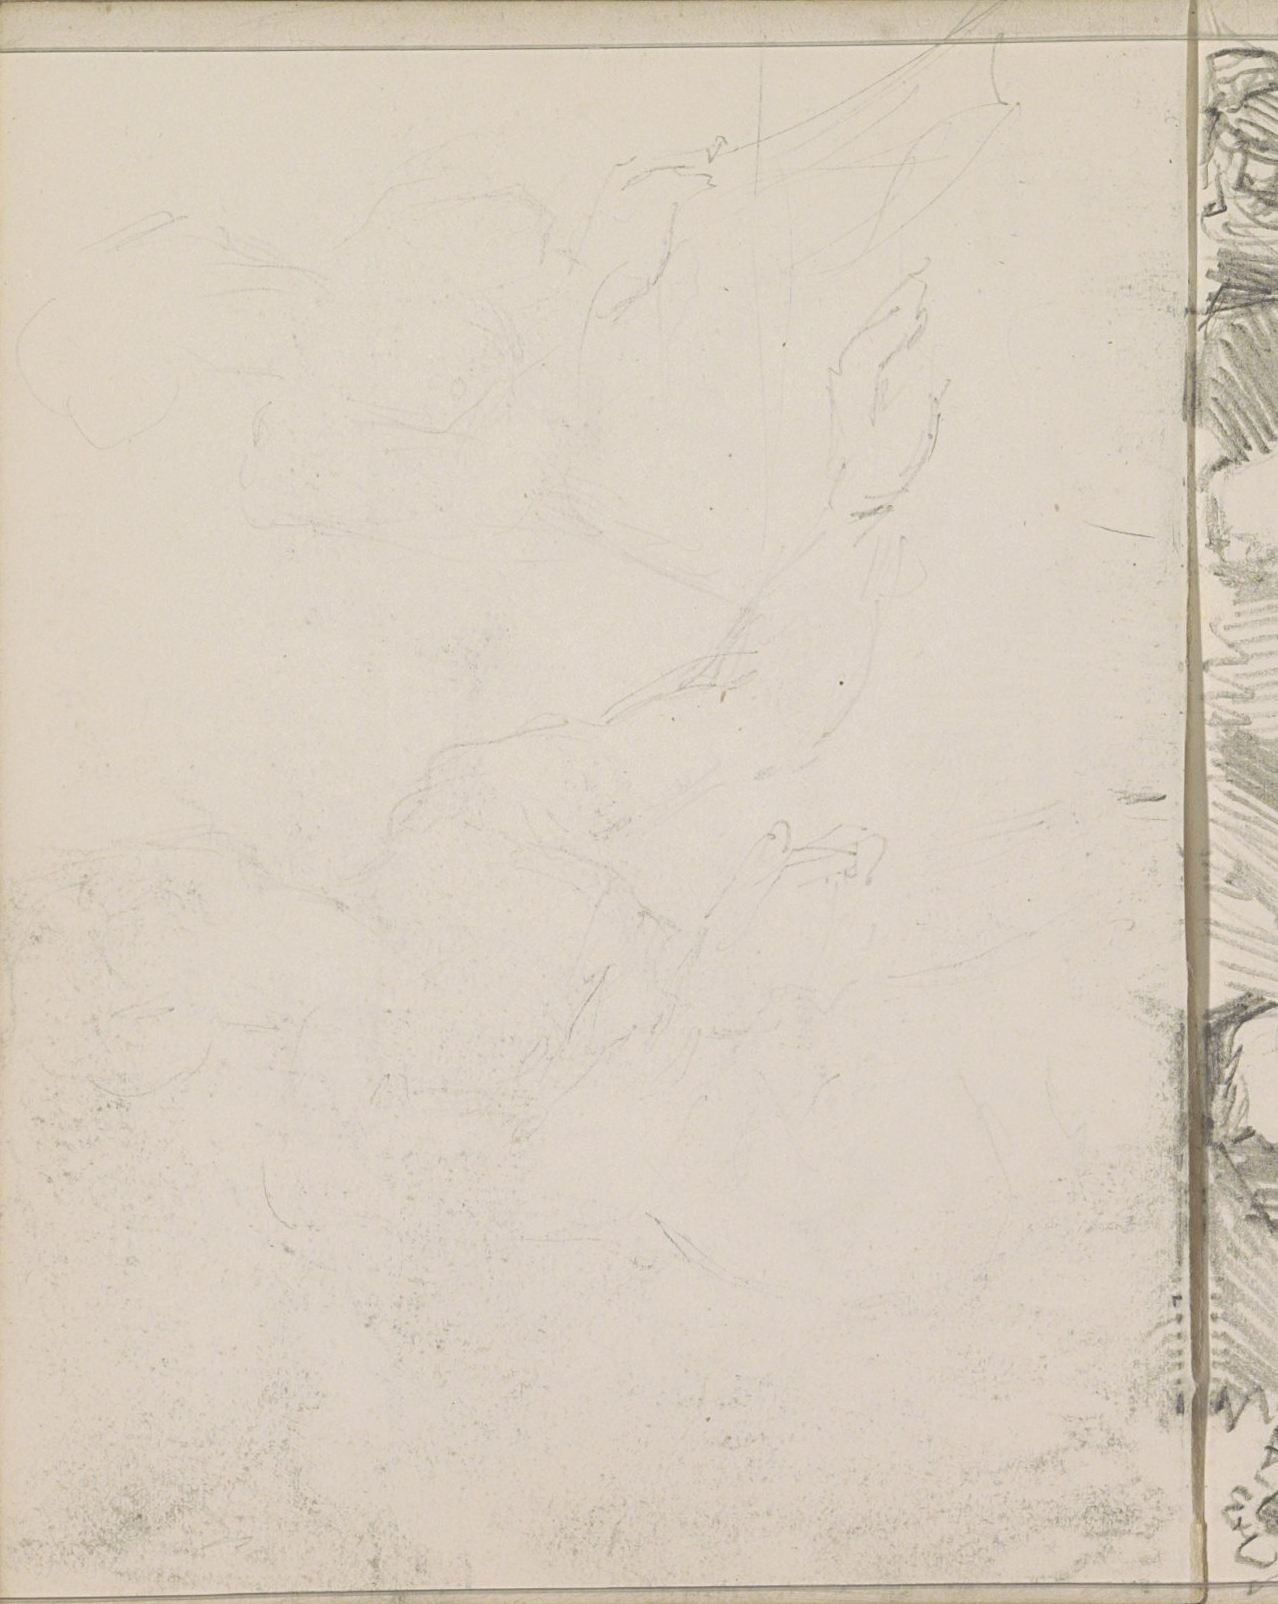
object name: sketchbook leaf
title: Figuur met opgeheven armen en een naakte vrouw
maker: reijer stolk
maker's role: draughtsman, print maker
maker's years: 1896-1945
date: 1916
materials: paper, pencil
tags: standing figure, the (nude) human figure; 'corpo humano' (ripa) - aa - female human figure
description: Blad 31 verso uit een schetsboek met 72 bladen.